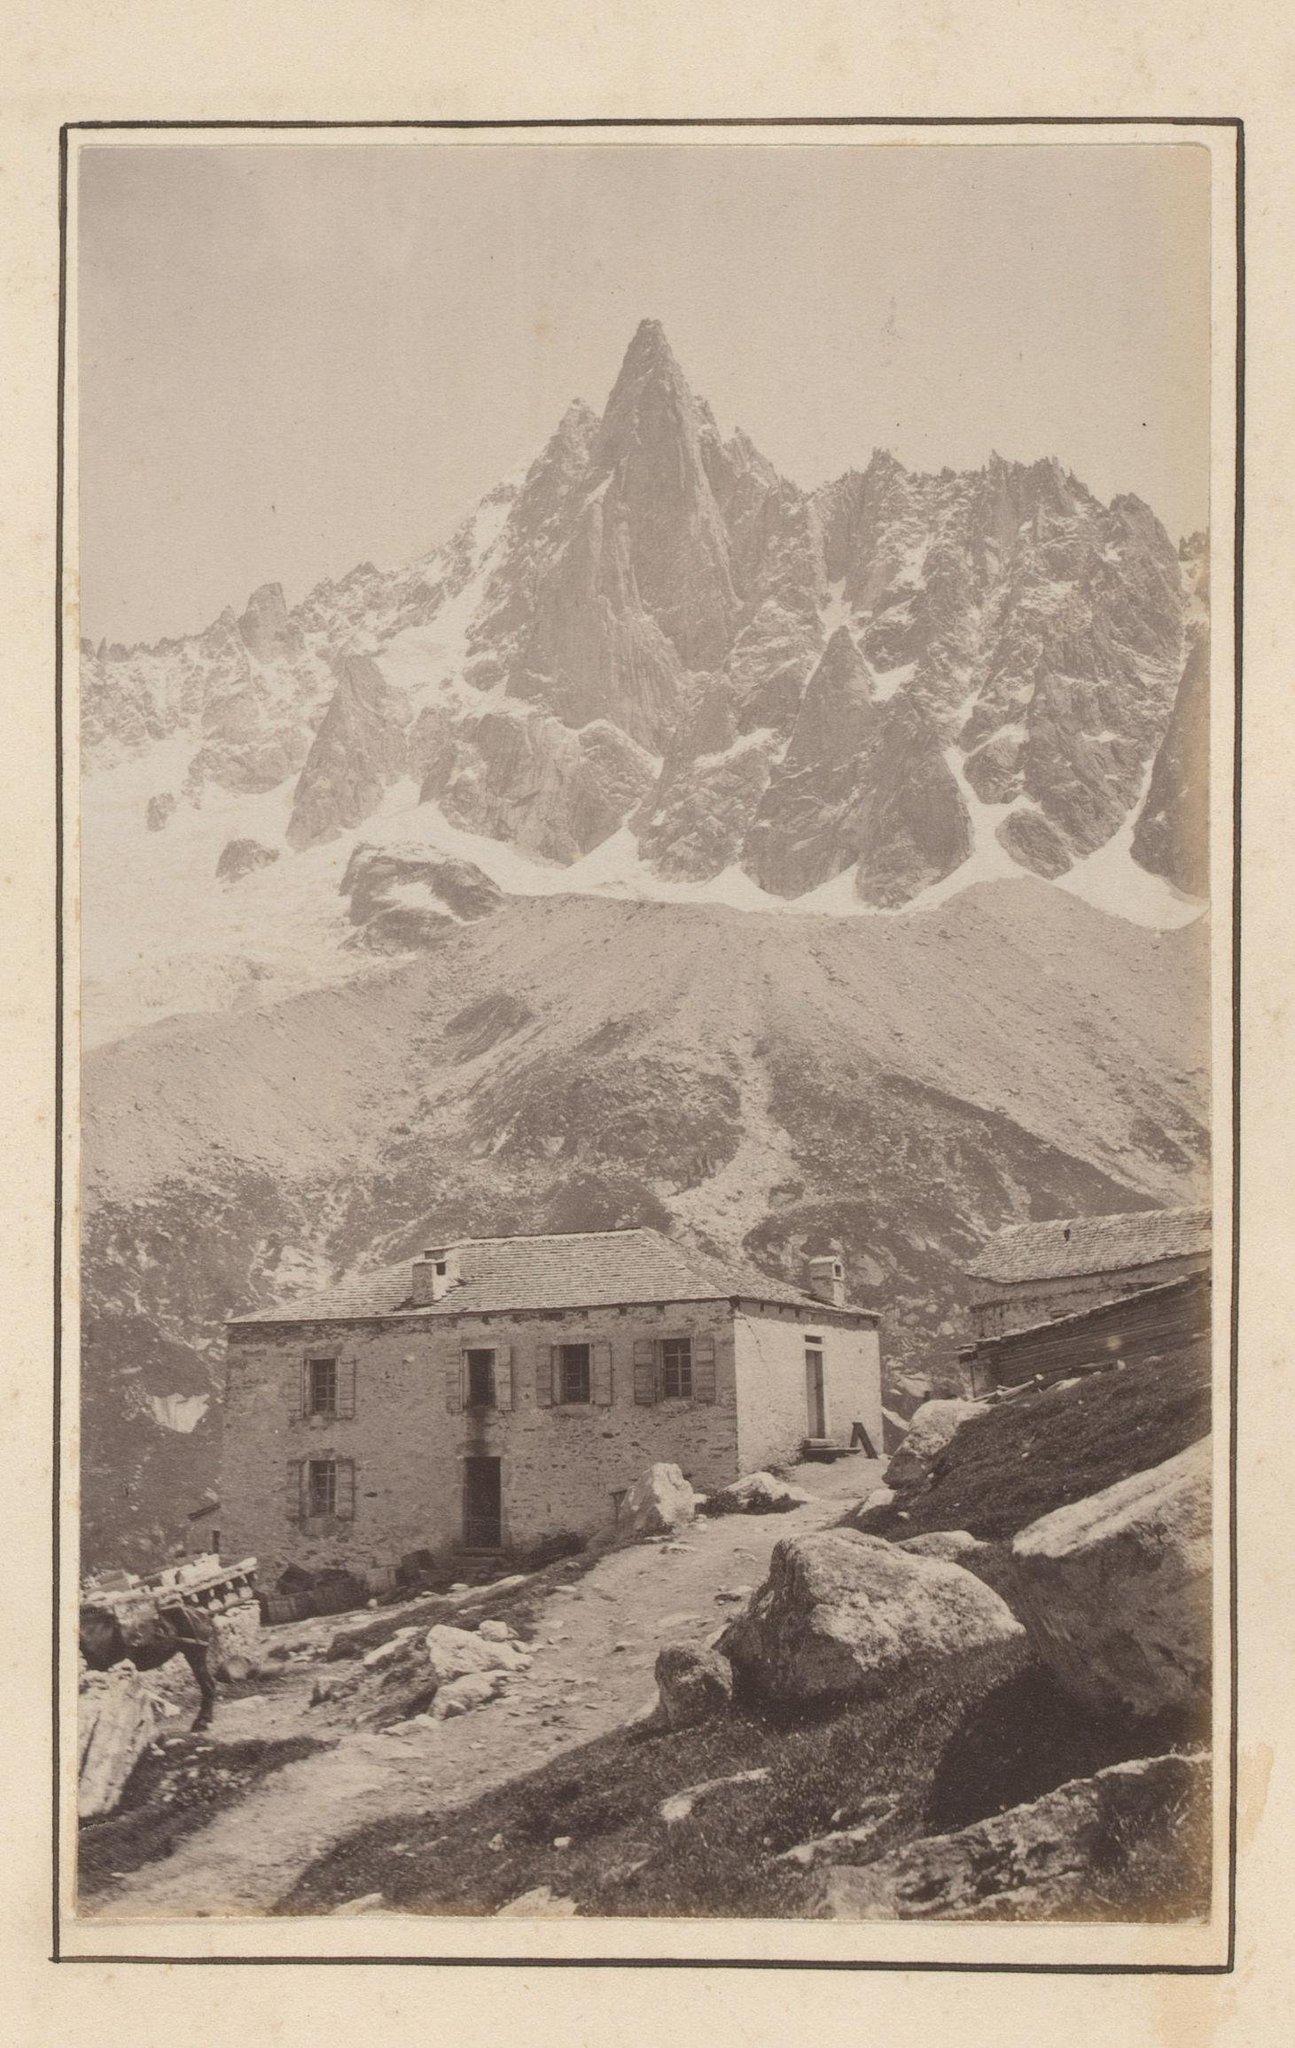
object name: album leaf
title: Twee vrouwen en twee mannen op een bergpad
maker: Anonymous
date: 1870-1890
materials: paper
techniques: albumen print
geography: switzerland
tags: mountain climbing, mountaineering, switzerland